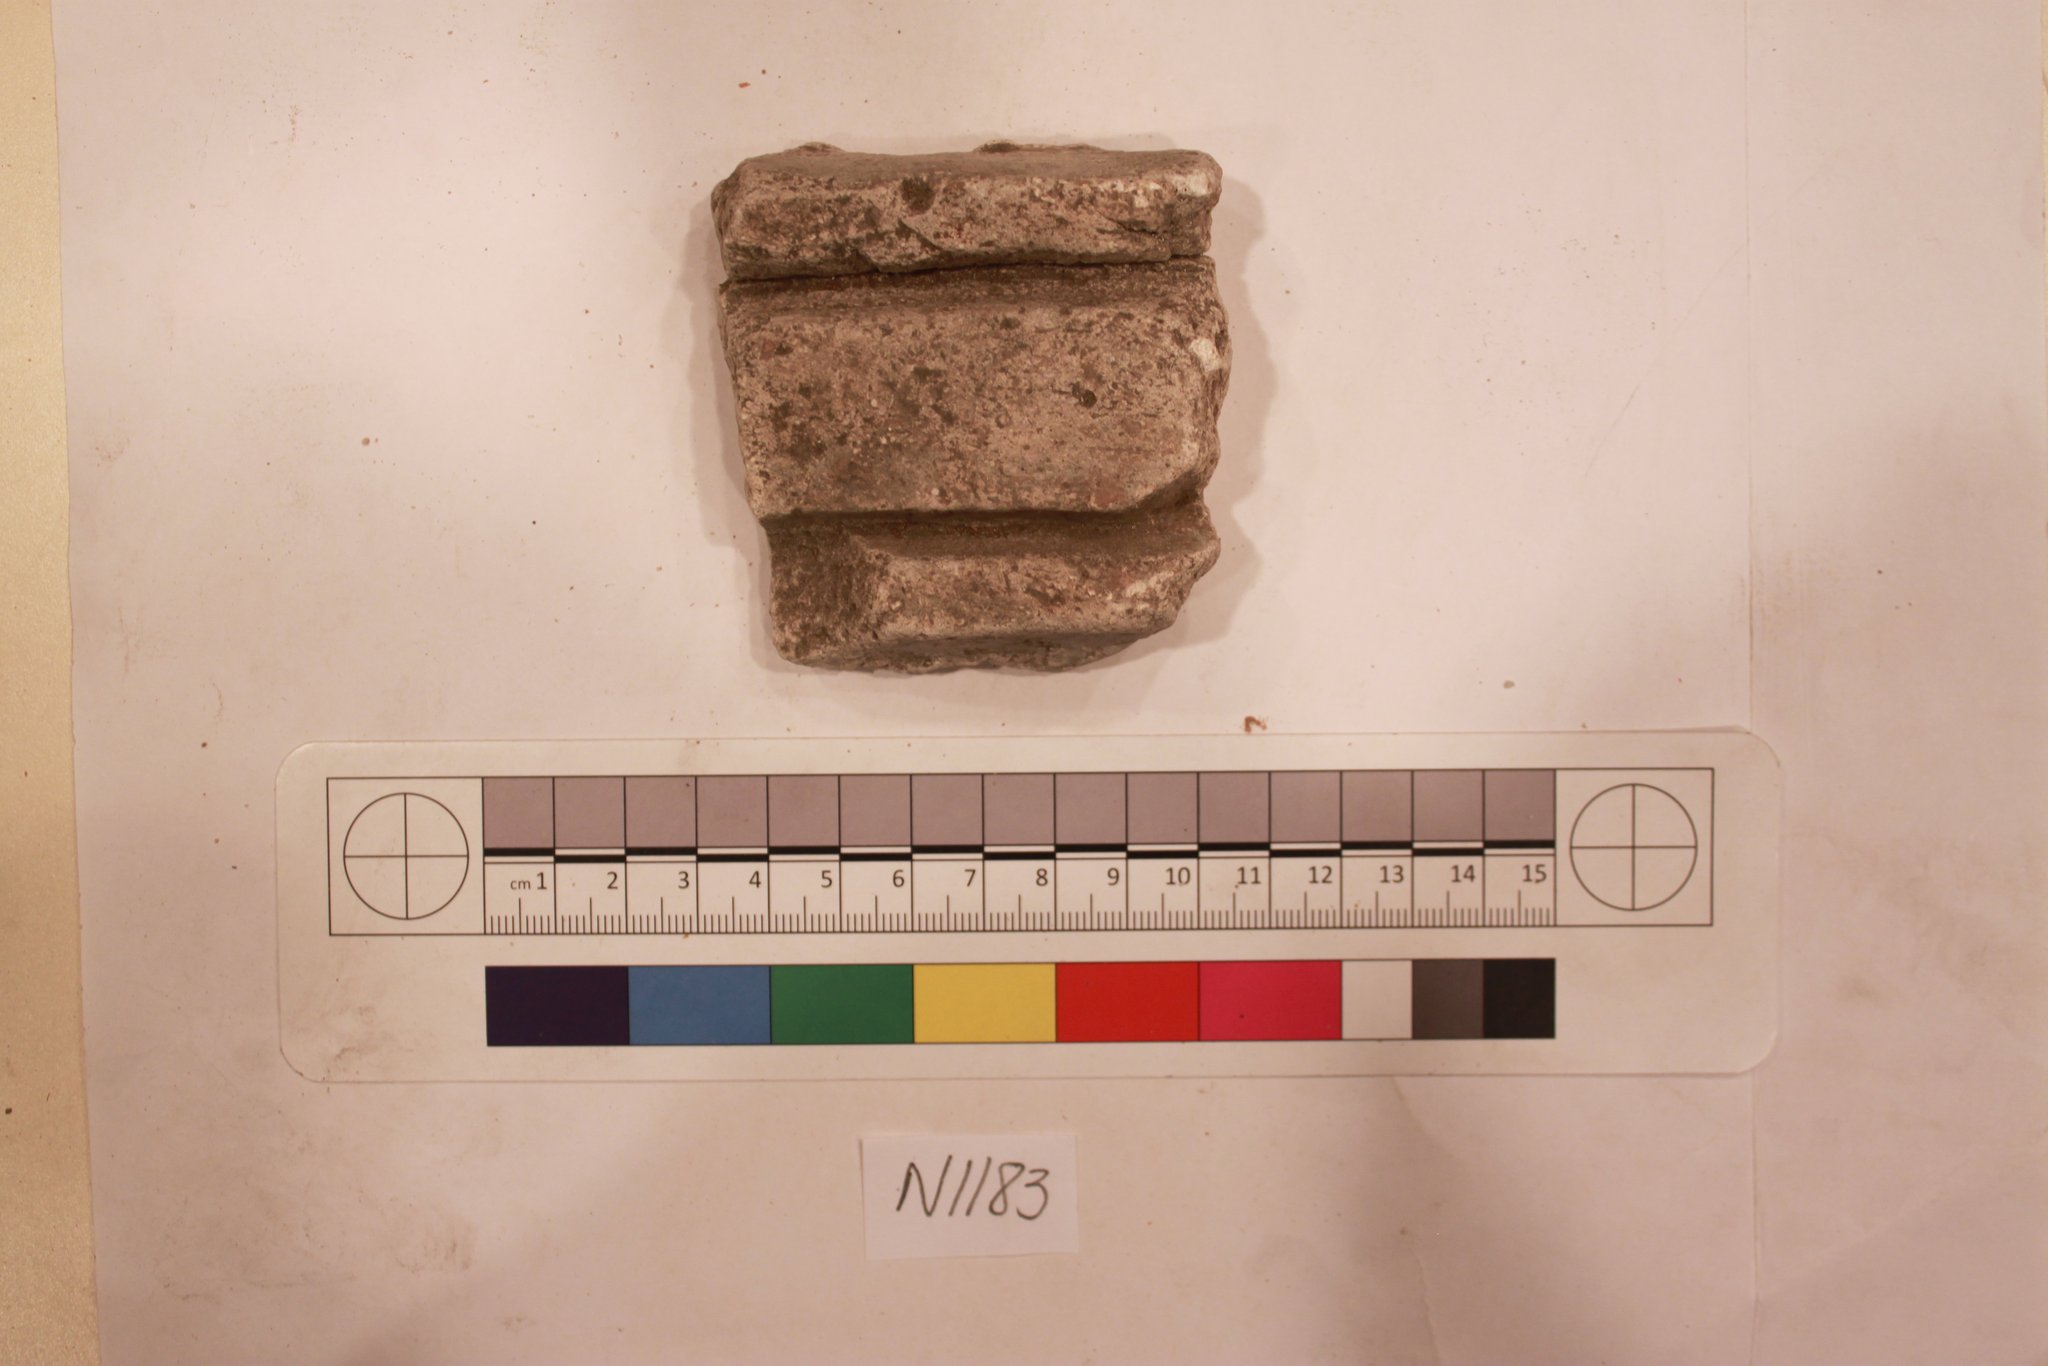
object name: fragment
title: Stucco Fragment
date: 701-1200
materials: plaster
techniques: carving, painting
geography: iran